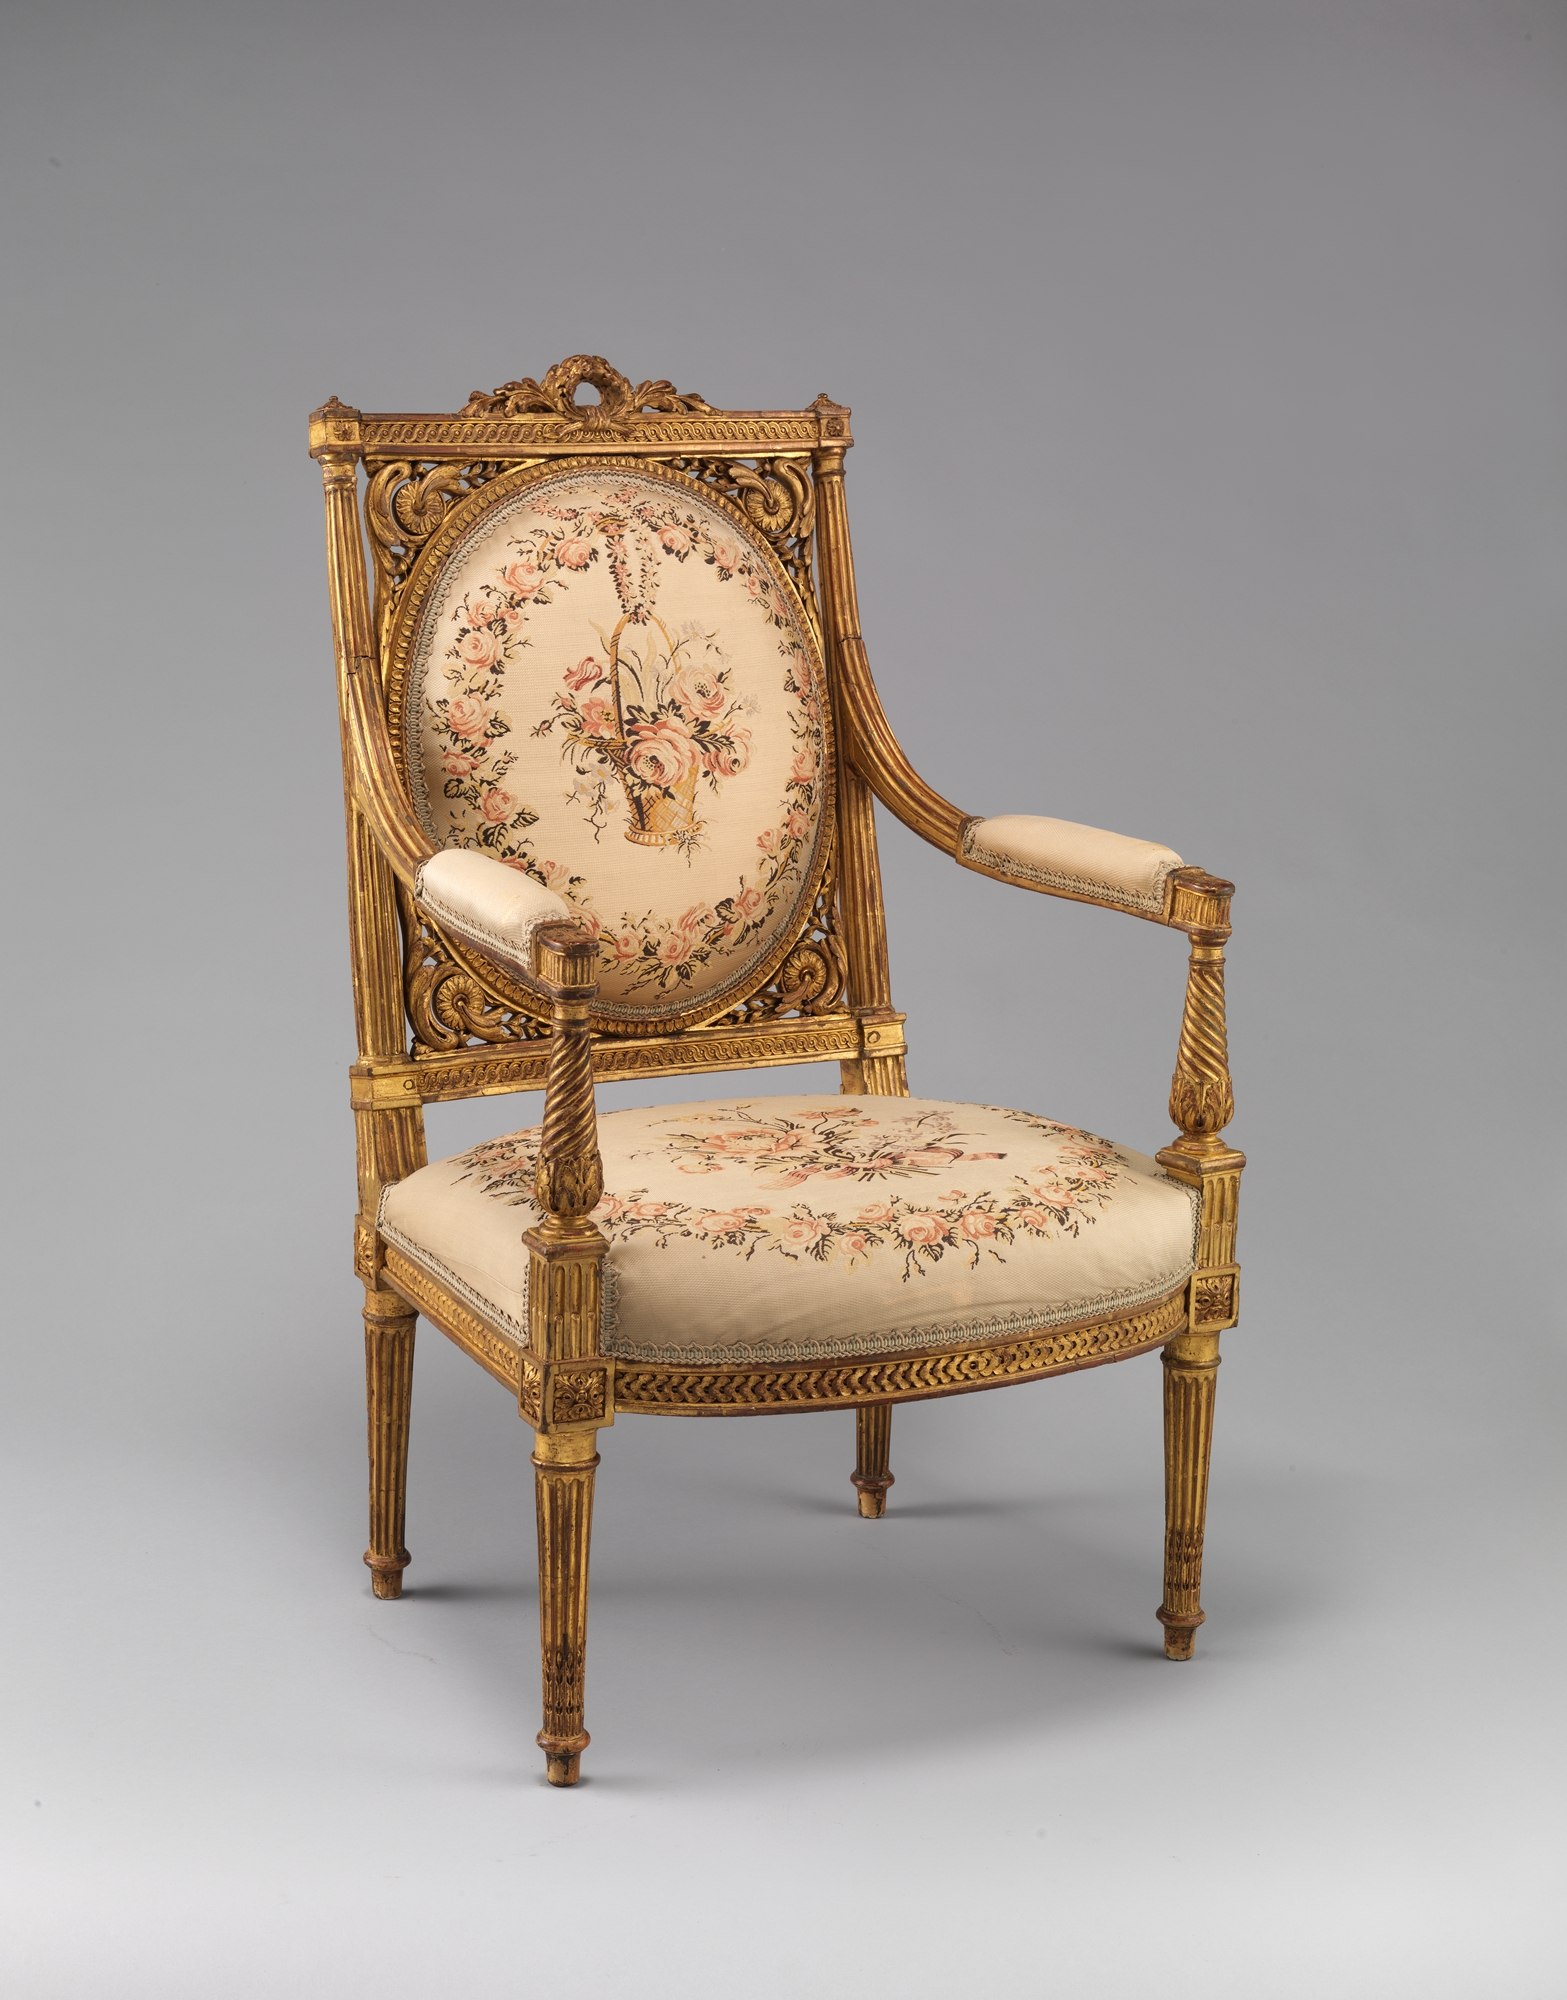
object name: armchair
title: Armchair (Fauteuil)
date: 1785-1790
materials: wood, silk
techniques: carving, gilding